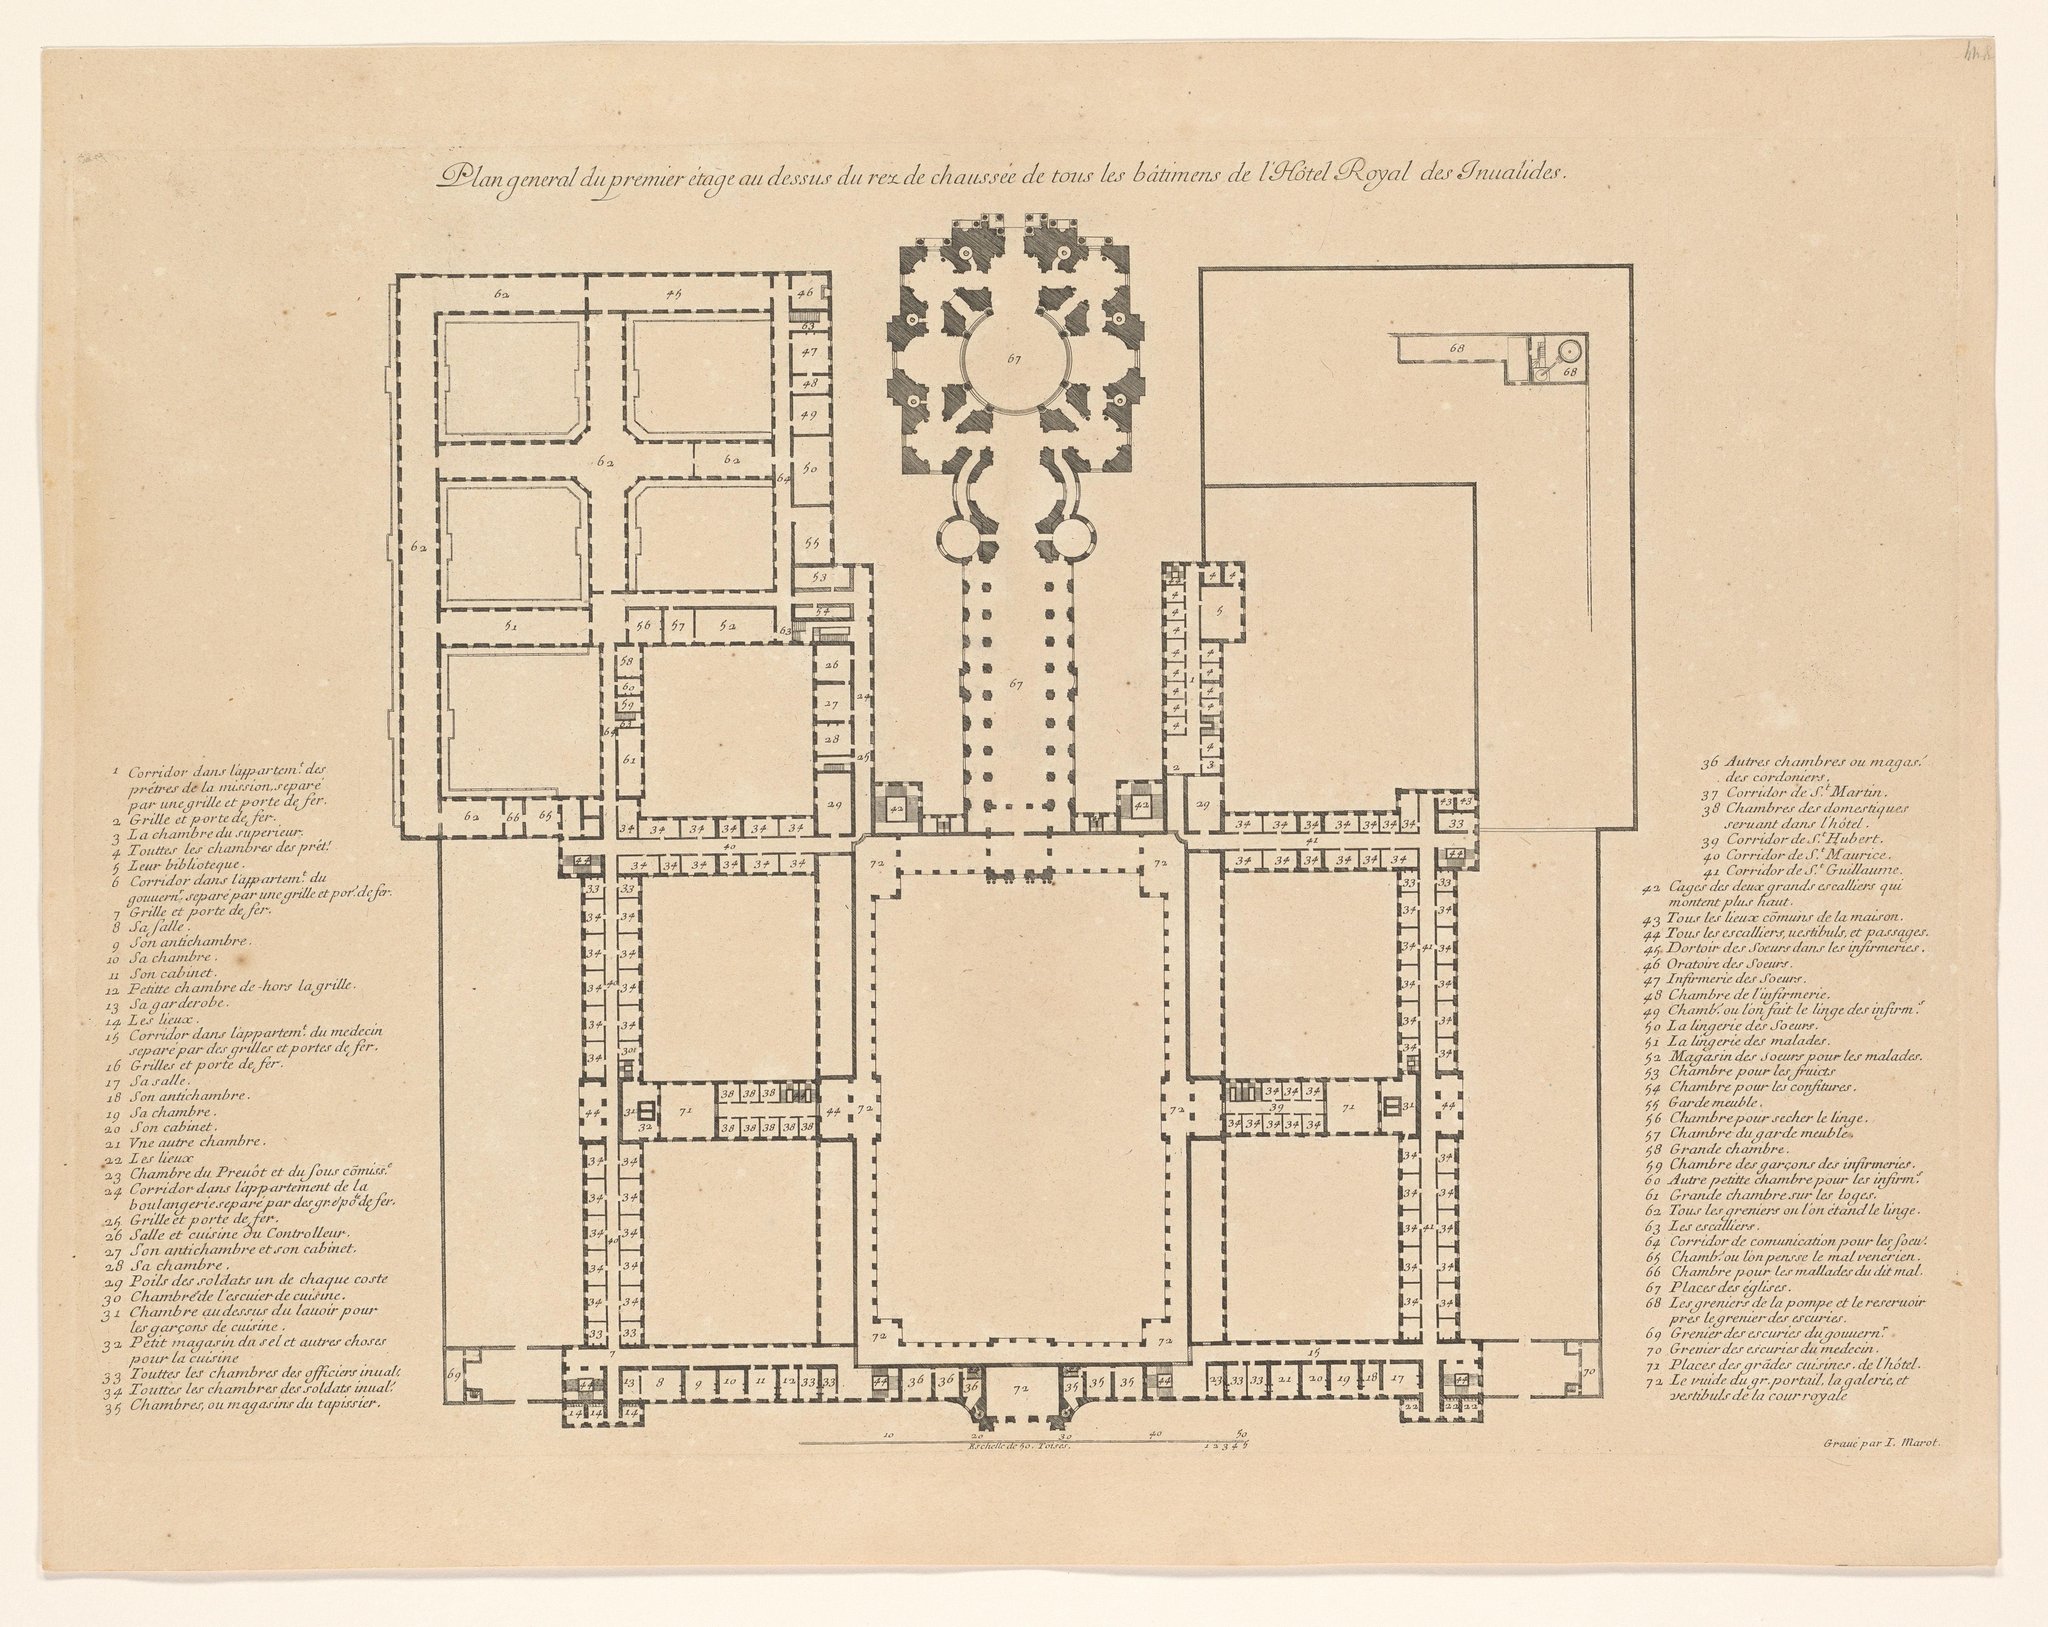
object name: print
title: Plattegrond van de eerste verdieping van het Hotel des Invalides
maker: jean marot (i)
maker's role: print maker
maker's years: 1619-1679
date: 1670-1679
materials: paper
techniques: etching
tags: plan ~ architecture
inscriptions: collector's mark: Lugt 1337, collector's mark: Lugt 2228